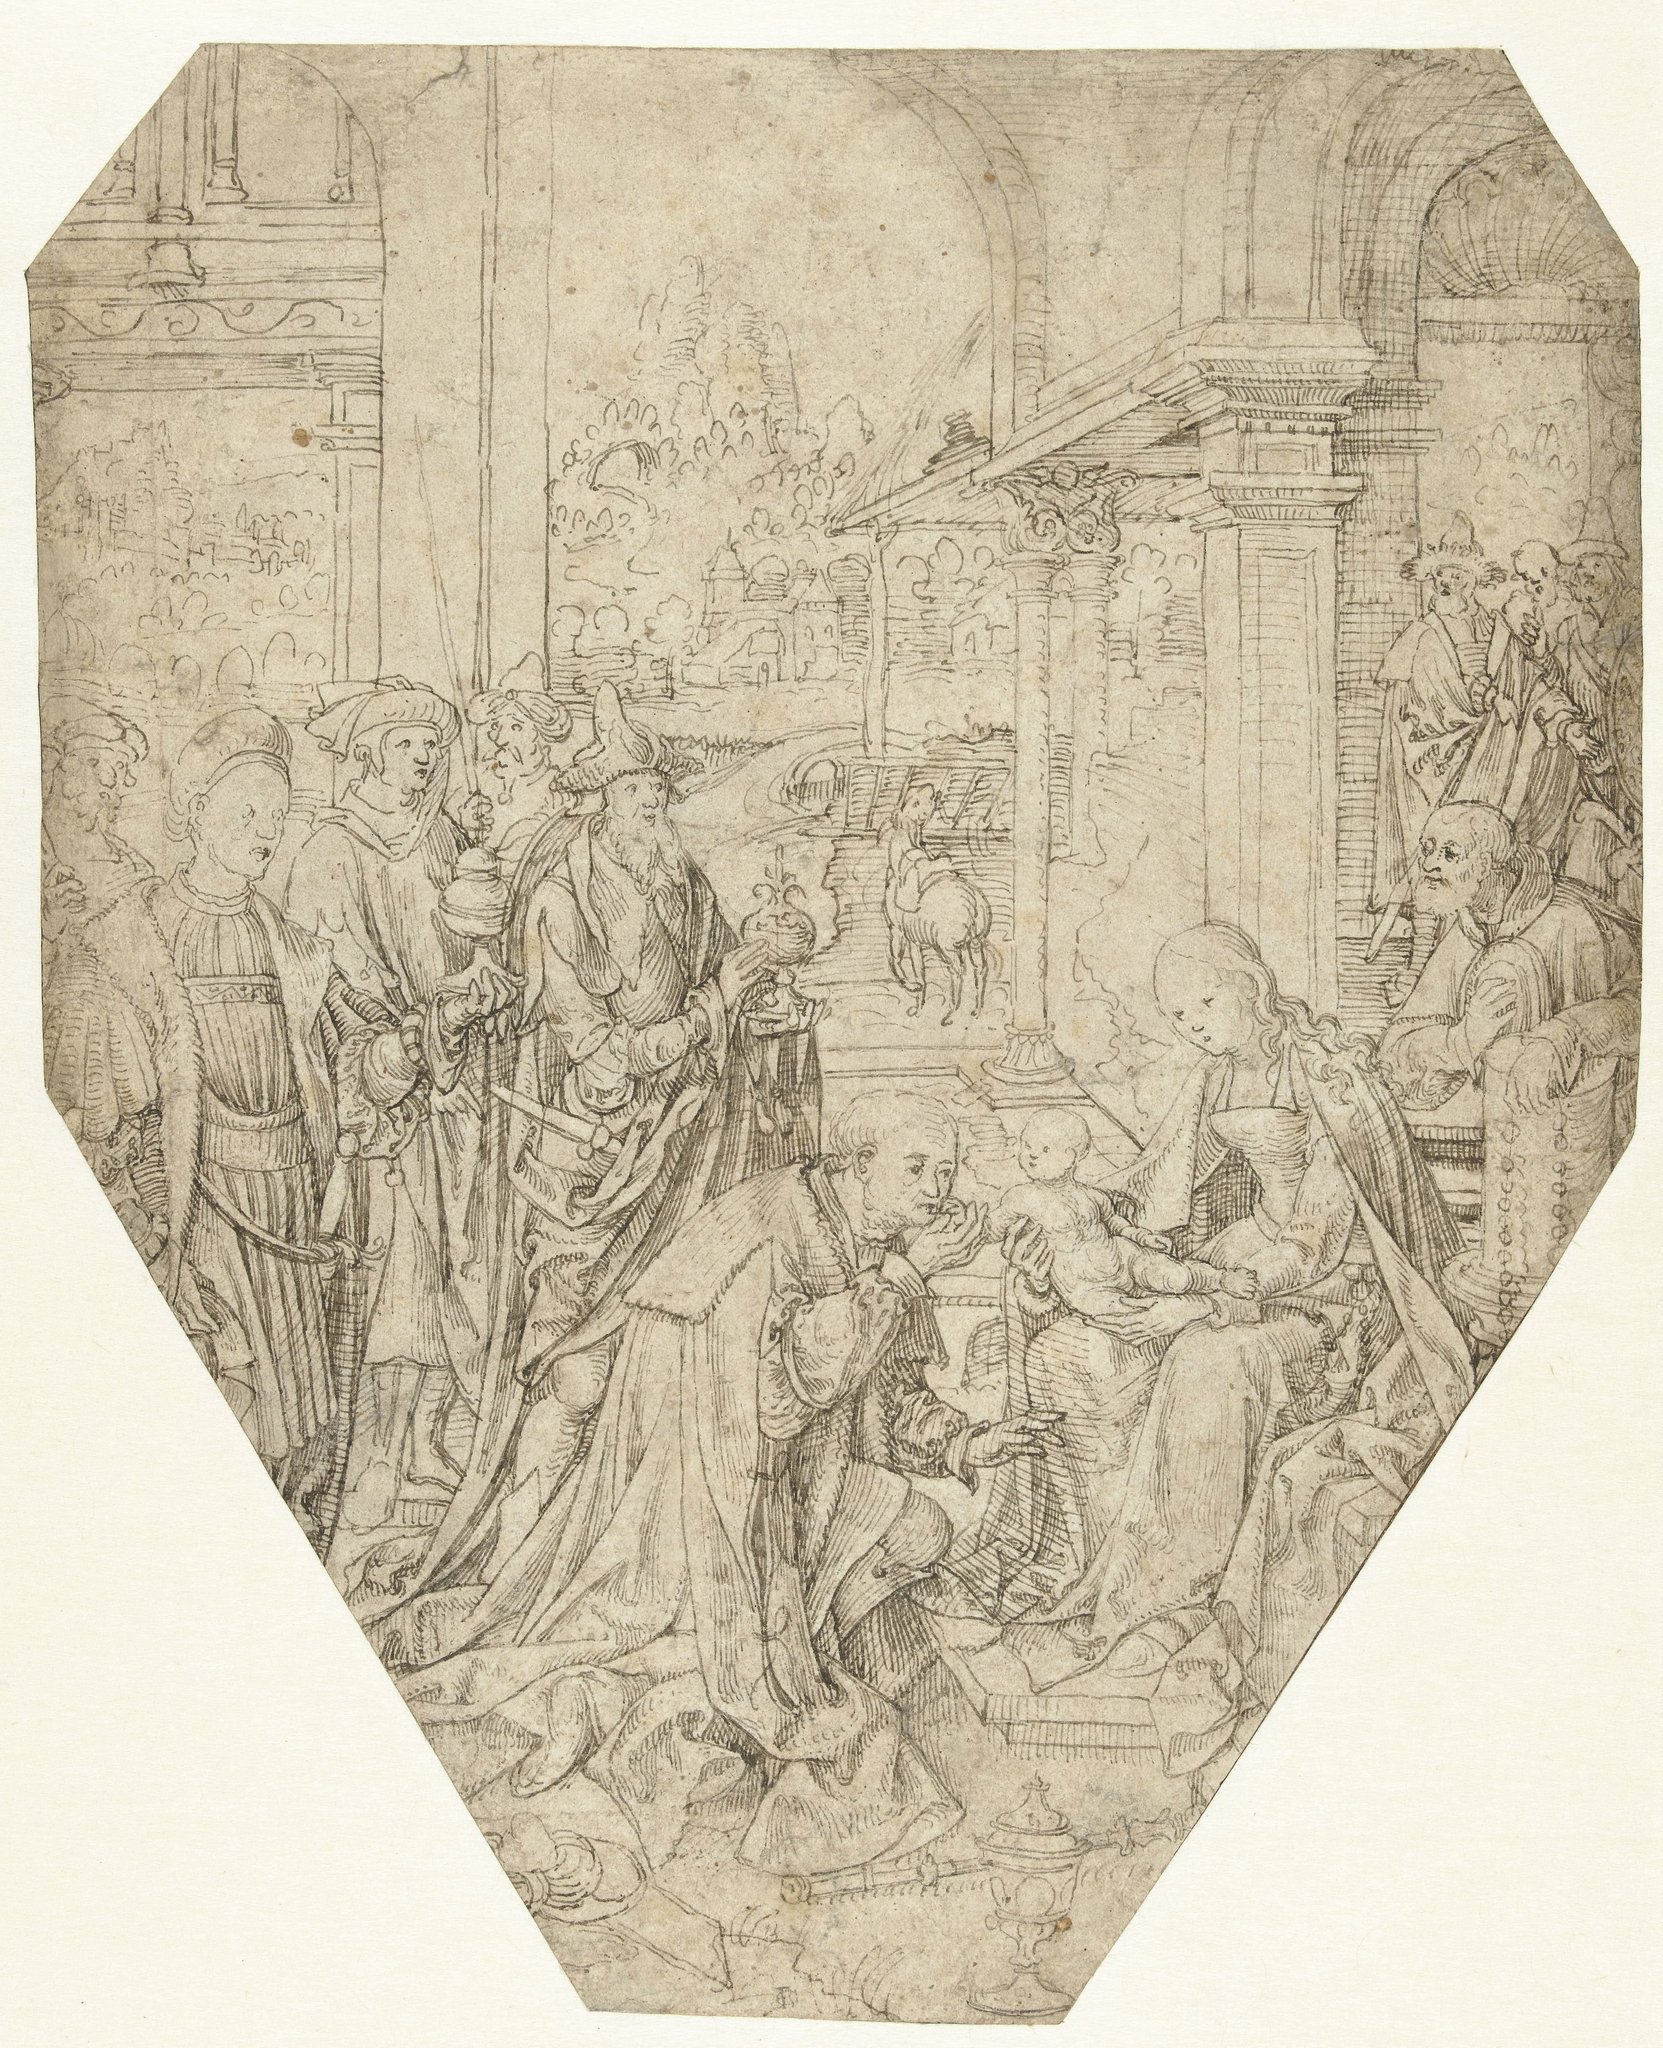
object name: design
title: Aanbidding der koningen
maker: joos van cleve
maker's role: draughtsman, painter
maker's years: 1485-1541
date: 1500-1550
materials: ink, paper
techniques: pen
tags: adoration of the kings: the wise men present their gifts to the christ-child (gold, frankincense and myrrh)